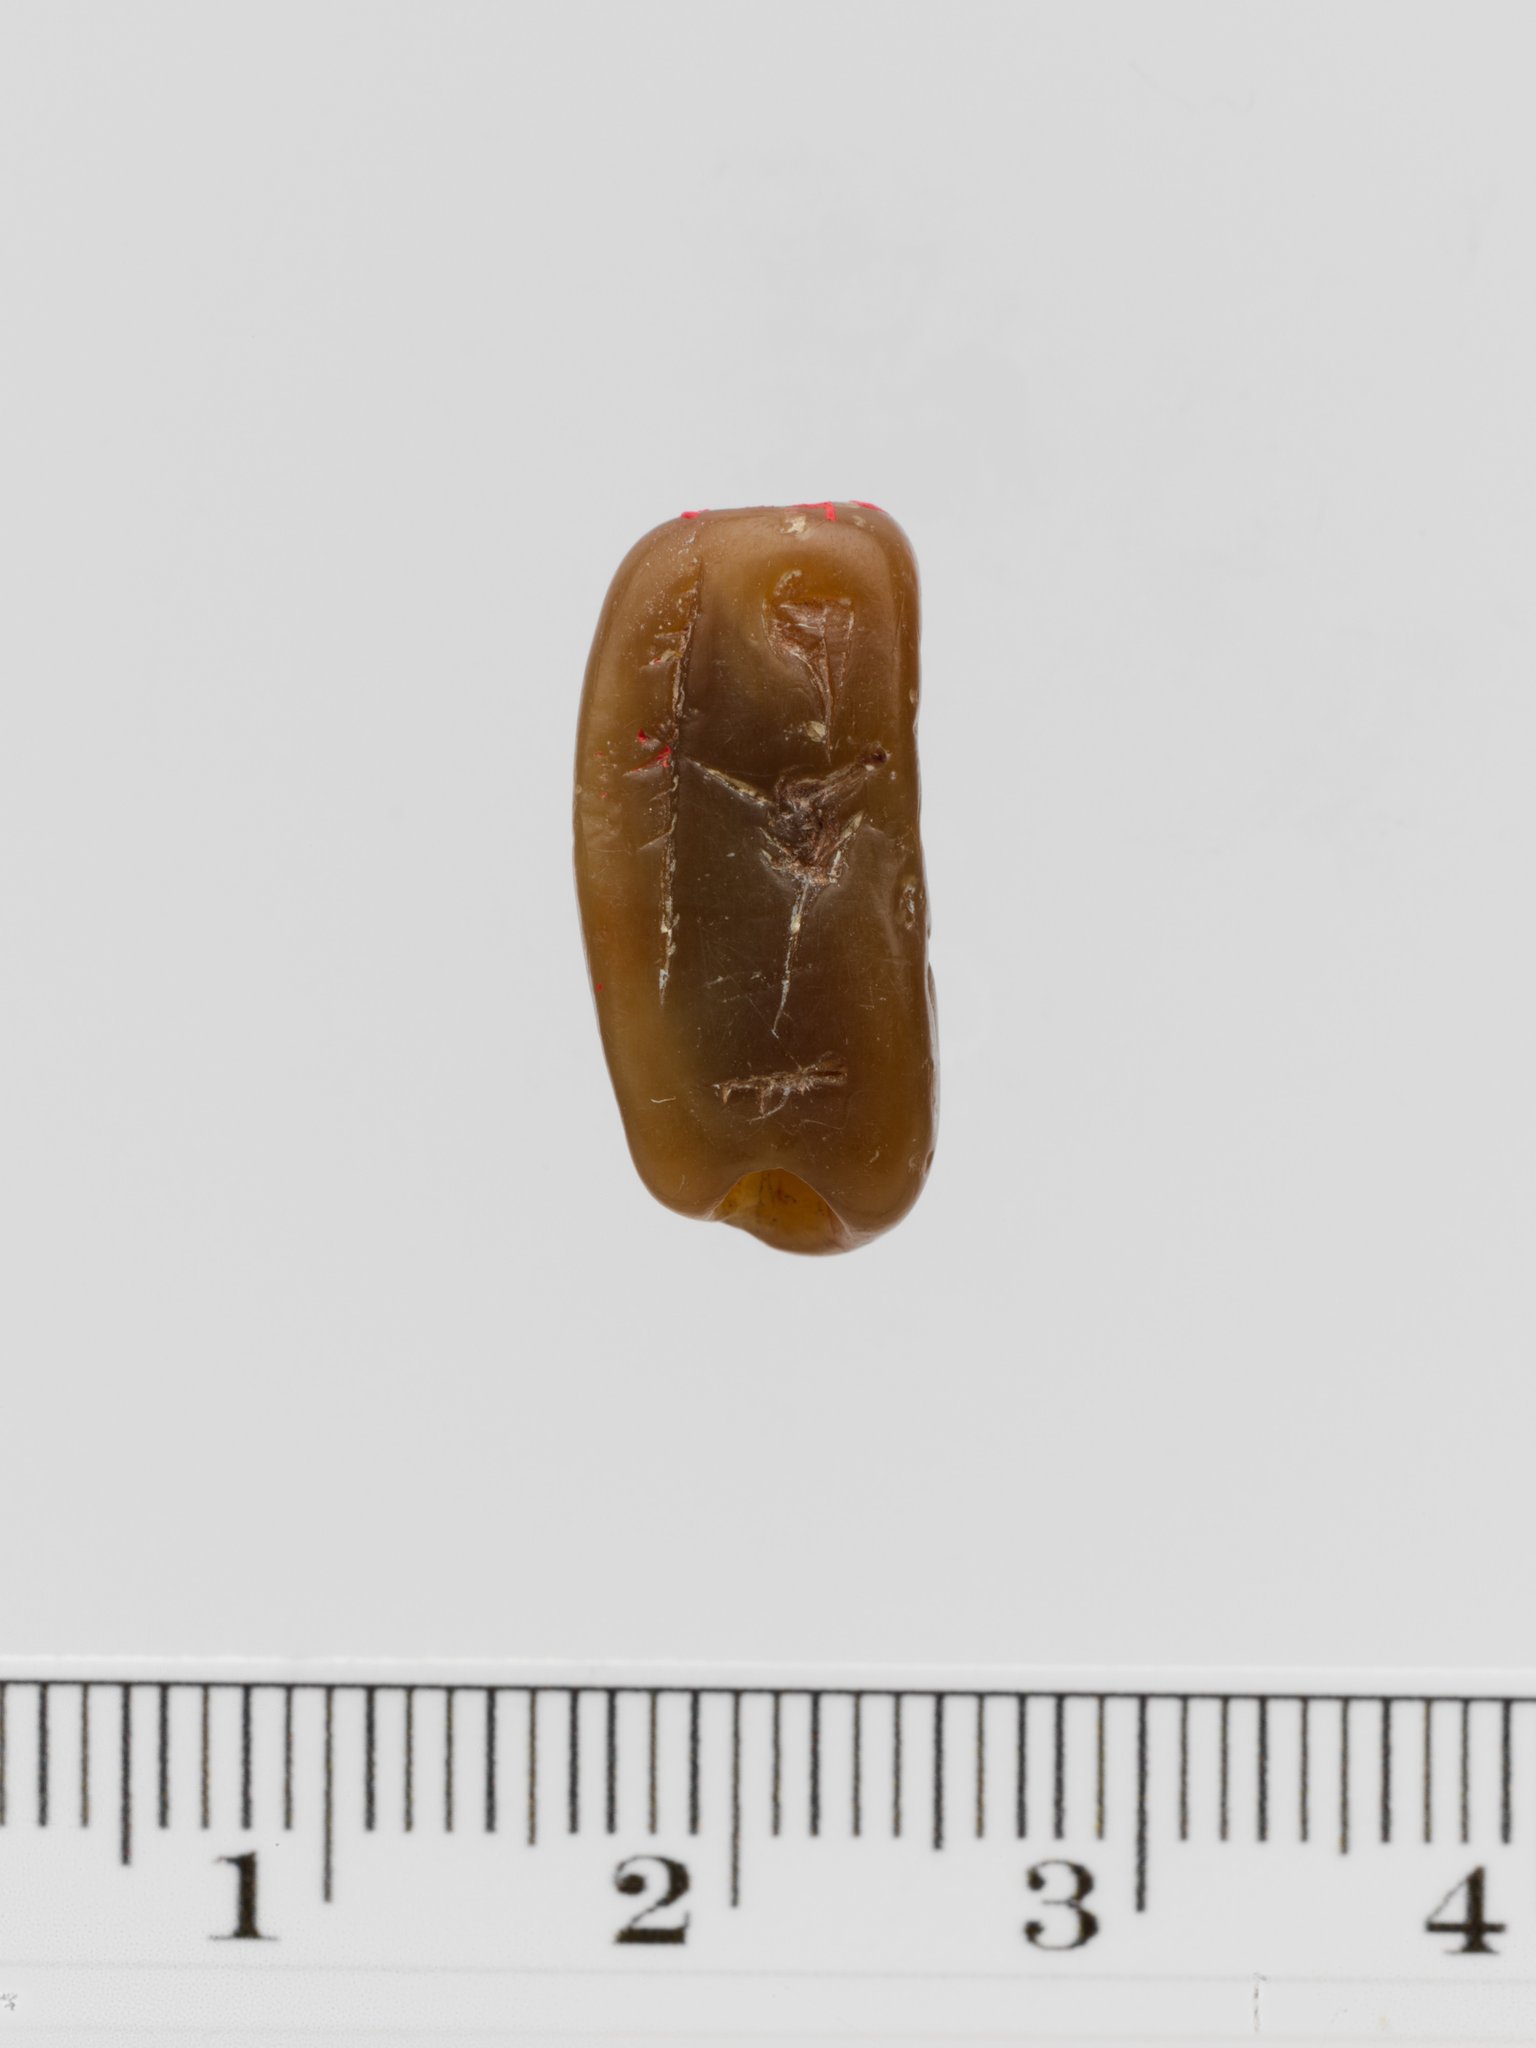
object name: seal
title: Steatite triangular prism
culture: minoan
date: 2400-1900 BCE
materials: stone